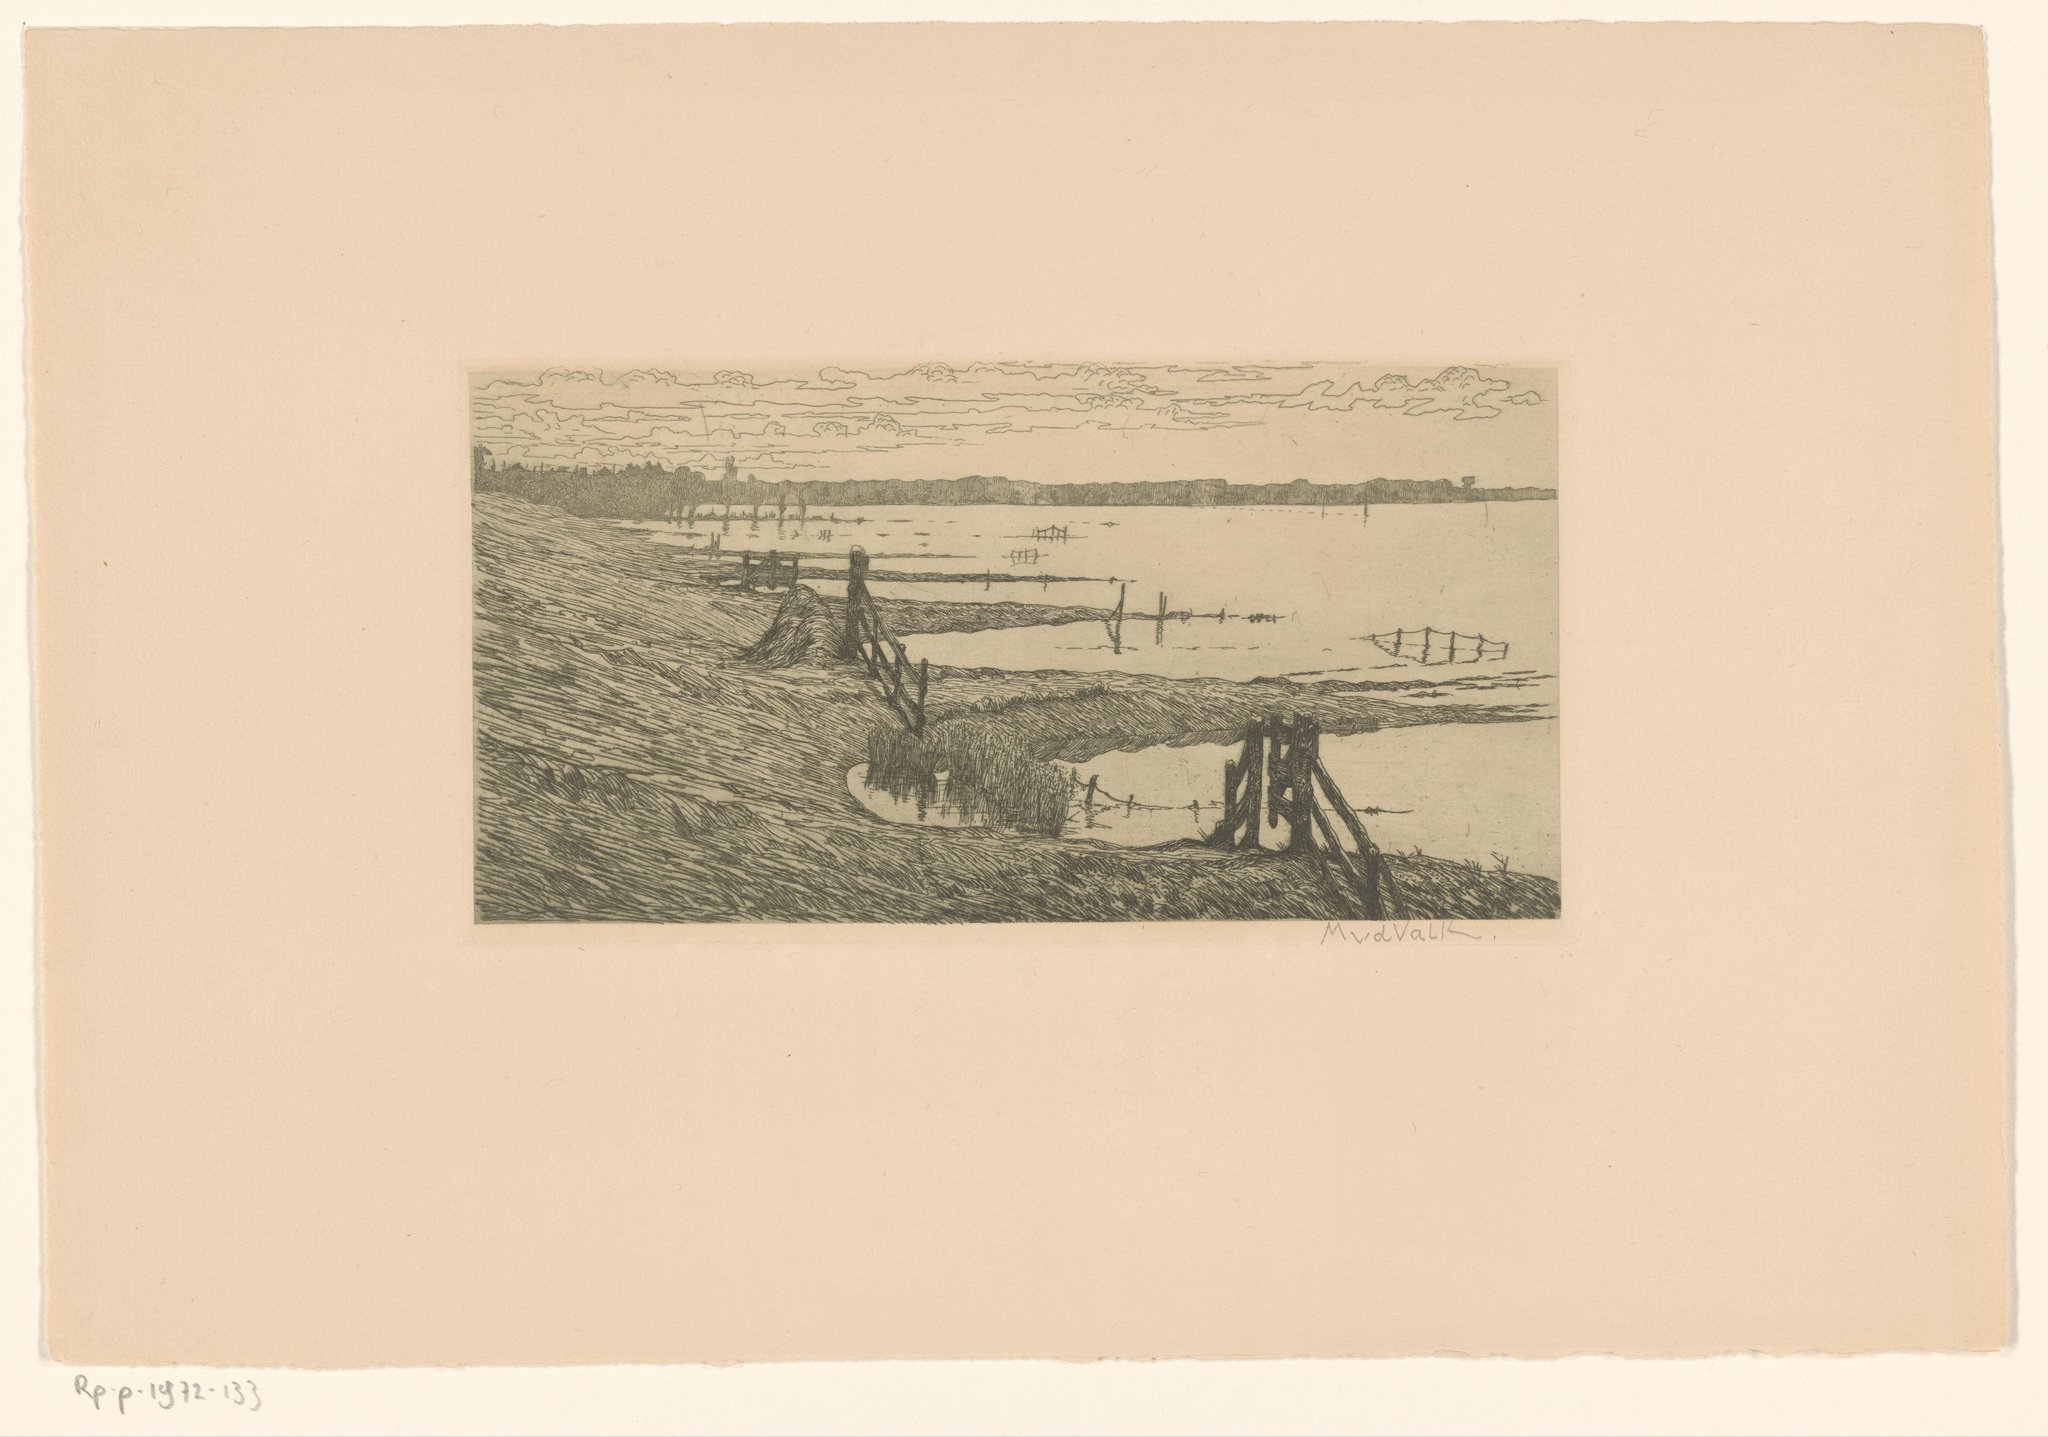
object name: print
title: Ondergelopen weilanden bij een dijk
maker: maurits van der valk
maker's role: draughtsman, print maker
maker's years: 1857-1935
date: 1867-1935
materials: paper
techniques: etching, intaglio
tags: water meadows under water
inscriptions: collector's mark: Lugt 2228, collector's mark: Lugt 2760